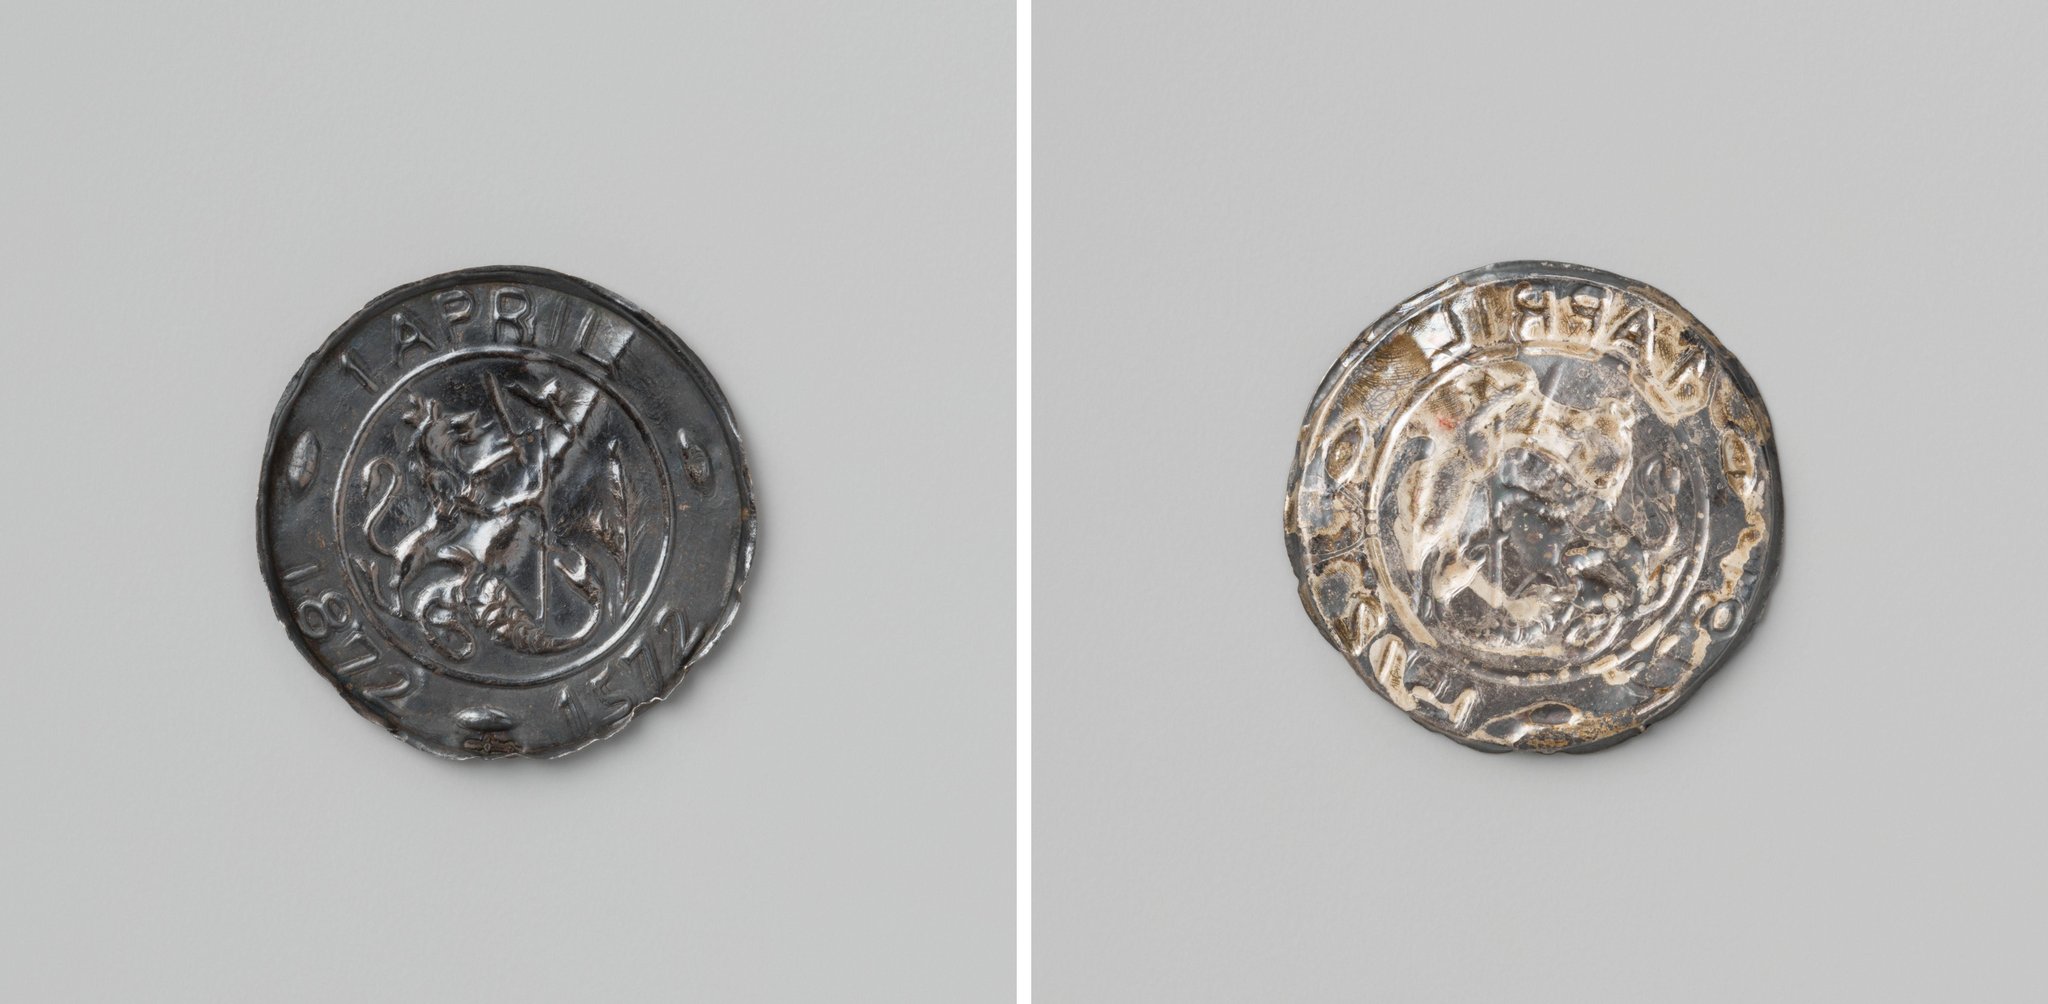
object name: plate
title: Driehonderdjarige herdenking van de inname van Den Briel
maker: Anonymous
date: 1872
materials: silver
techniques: striking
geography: netherlands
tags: brielle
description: Eenzijdig zilveren plaatje, plaatje en ringetje afkomstig van houten, oranje geverfde knoop. Voorzijde: gekroonde leeuw met zwaard en vrijheidshoed op speer vertrapt ter aarde liggende draak binnen omschrift. Keerzijde: blanco.